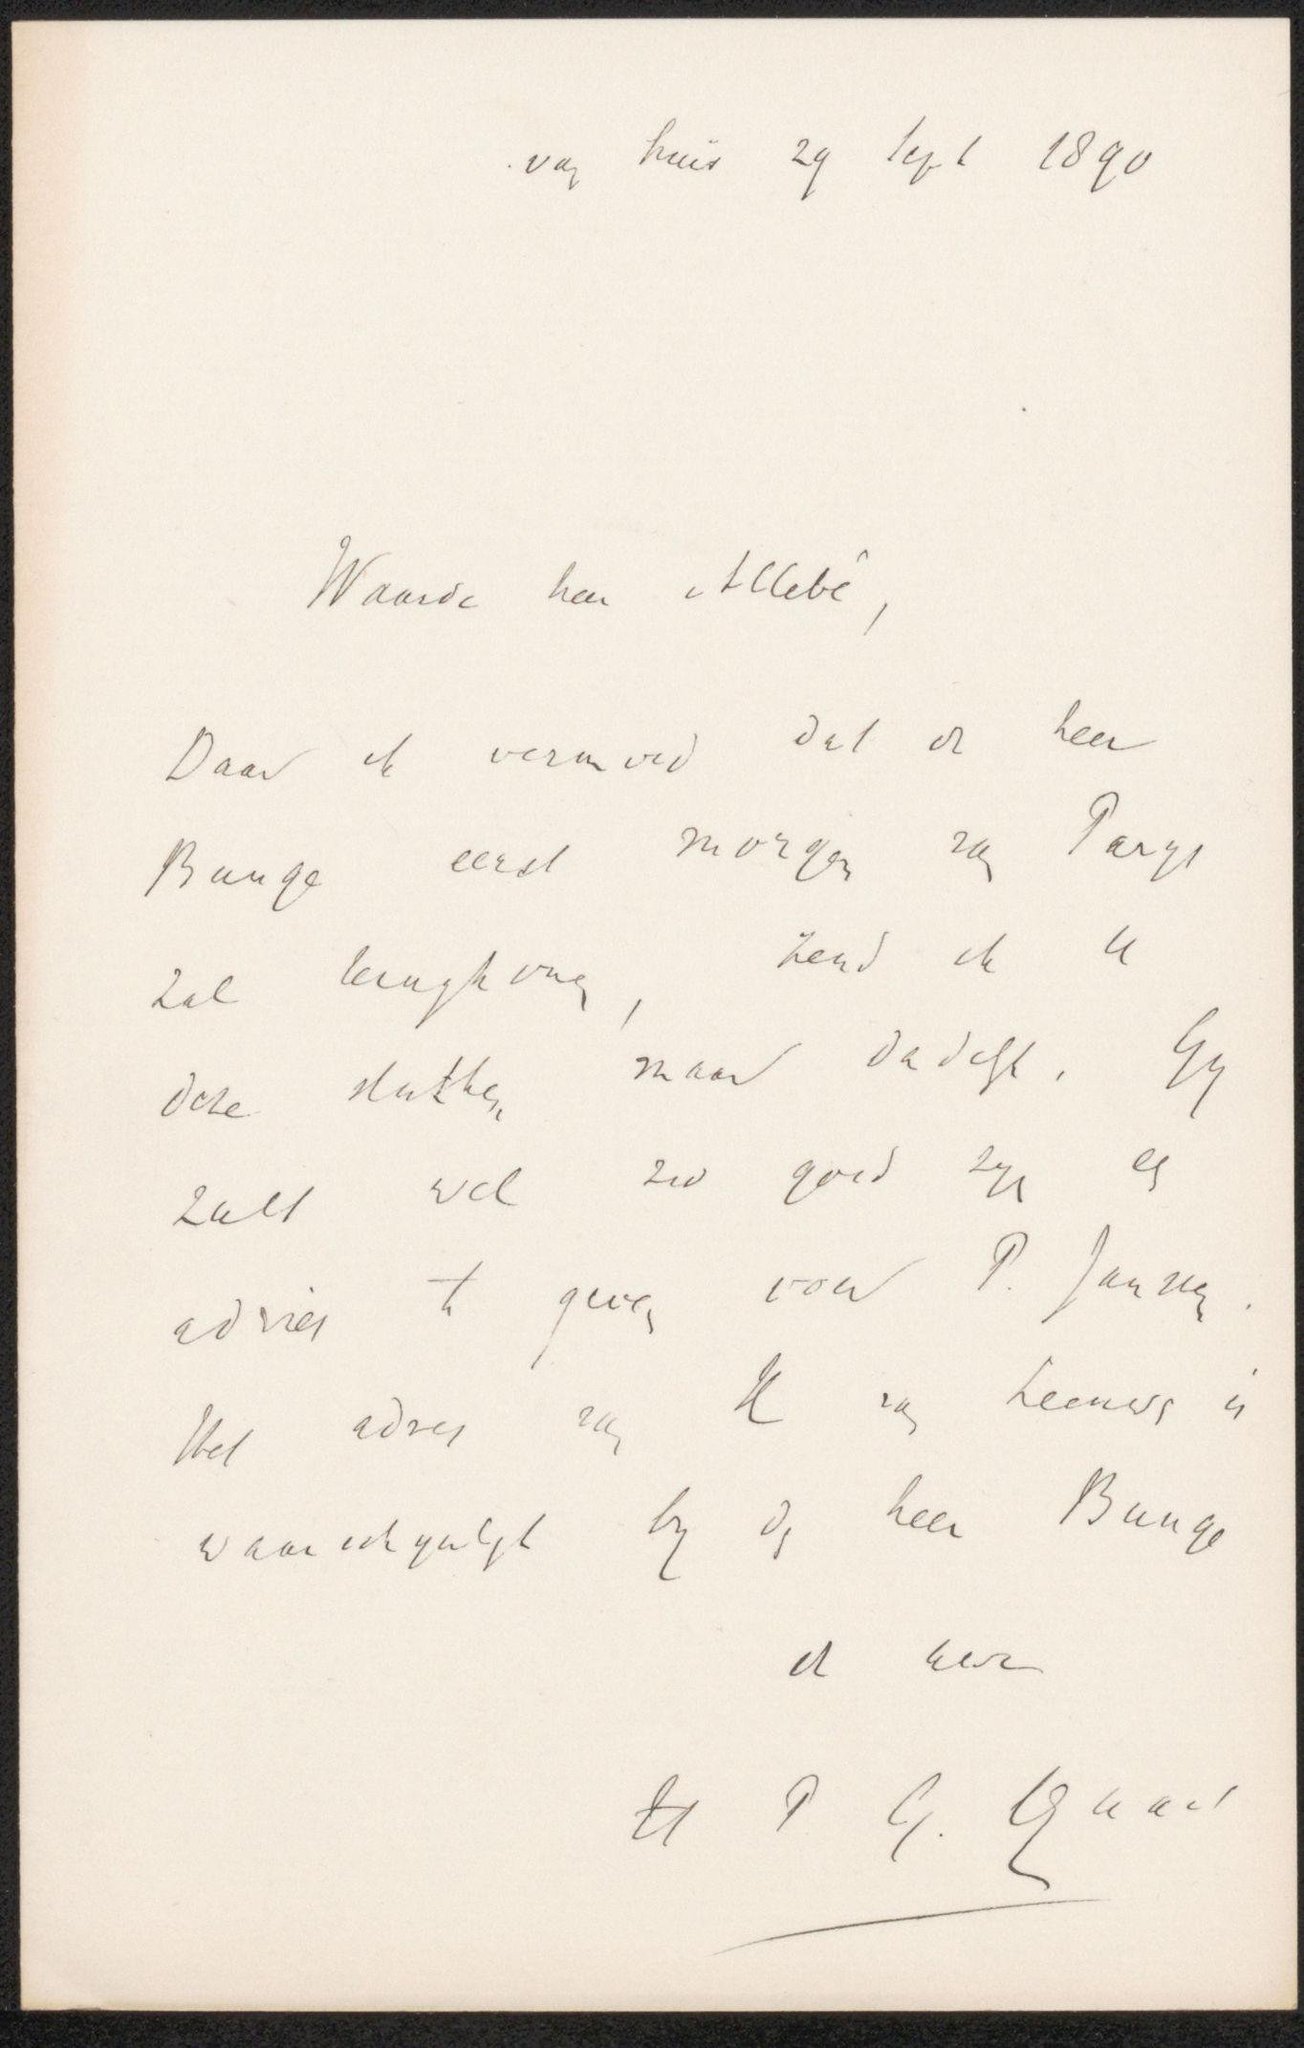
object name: letter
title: Brief aan August Allebé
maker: hendrick peter godfried quack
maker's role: econoom, geschiedschrijver, hoogleraar, jurist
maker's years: 1834-1917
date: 1890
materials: ink, paper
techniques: pen, writing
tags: draughtsman, august allebé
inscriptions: watermark